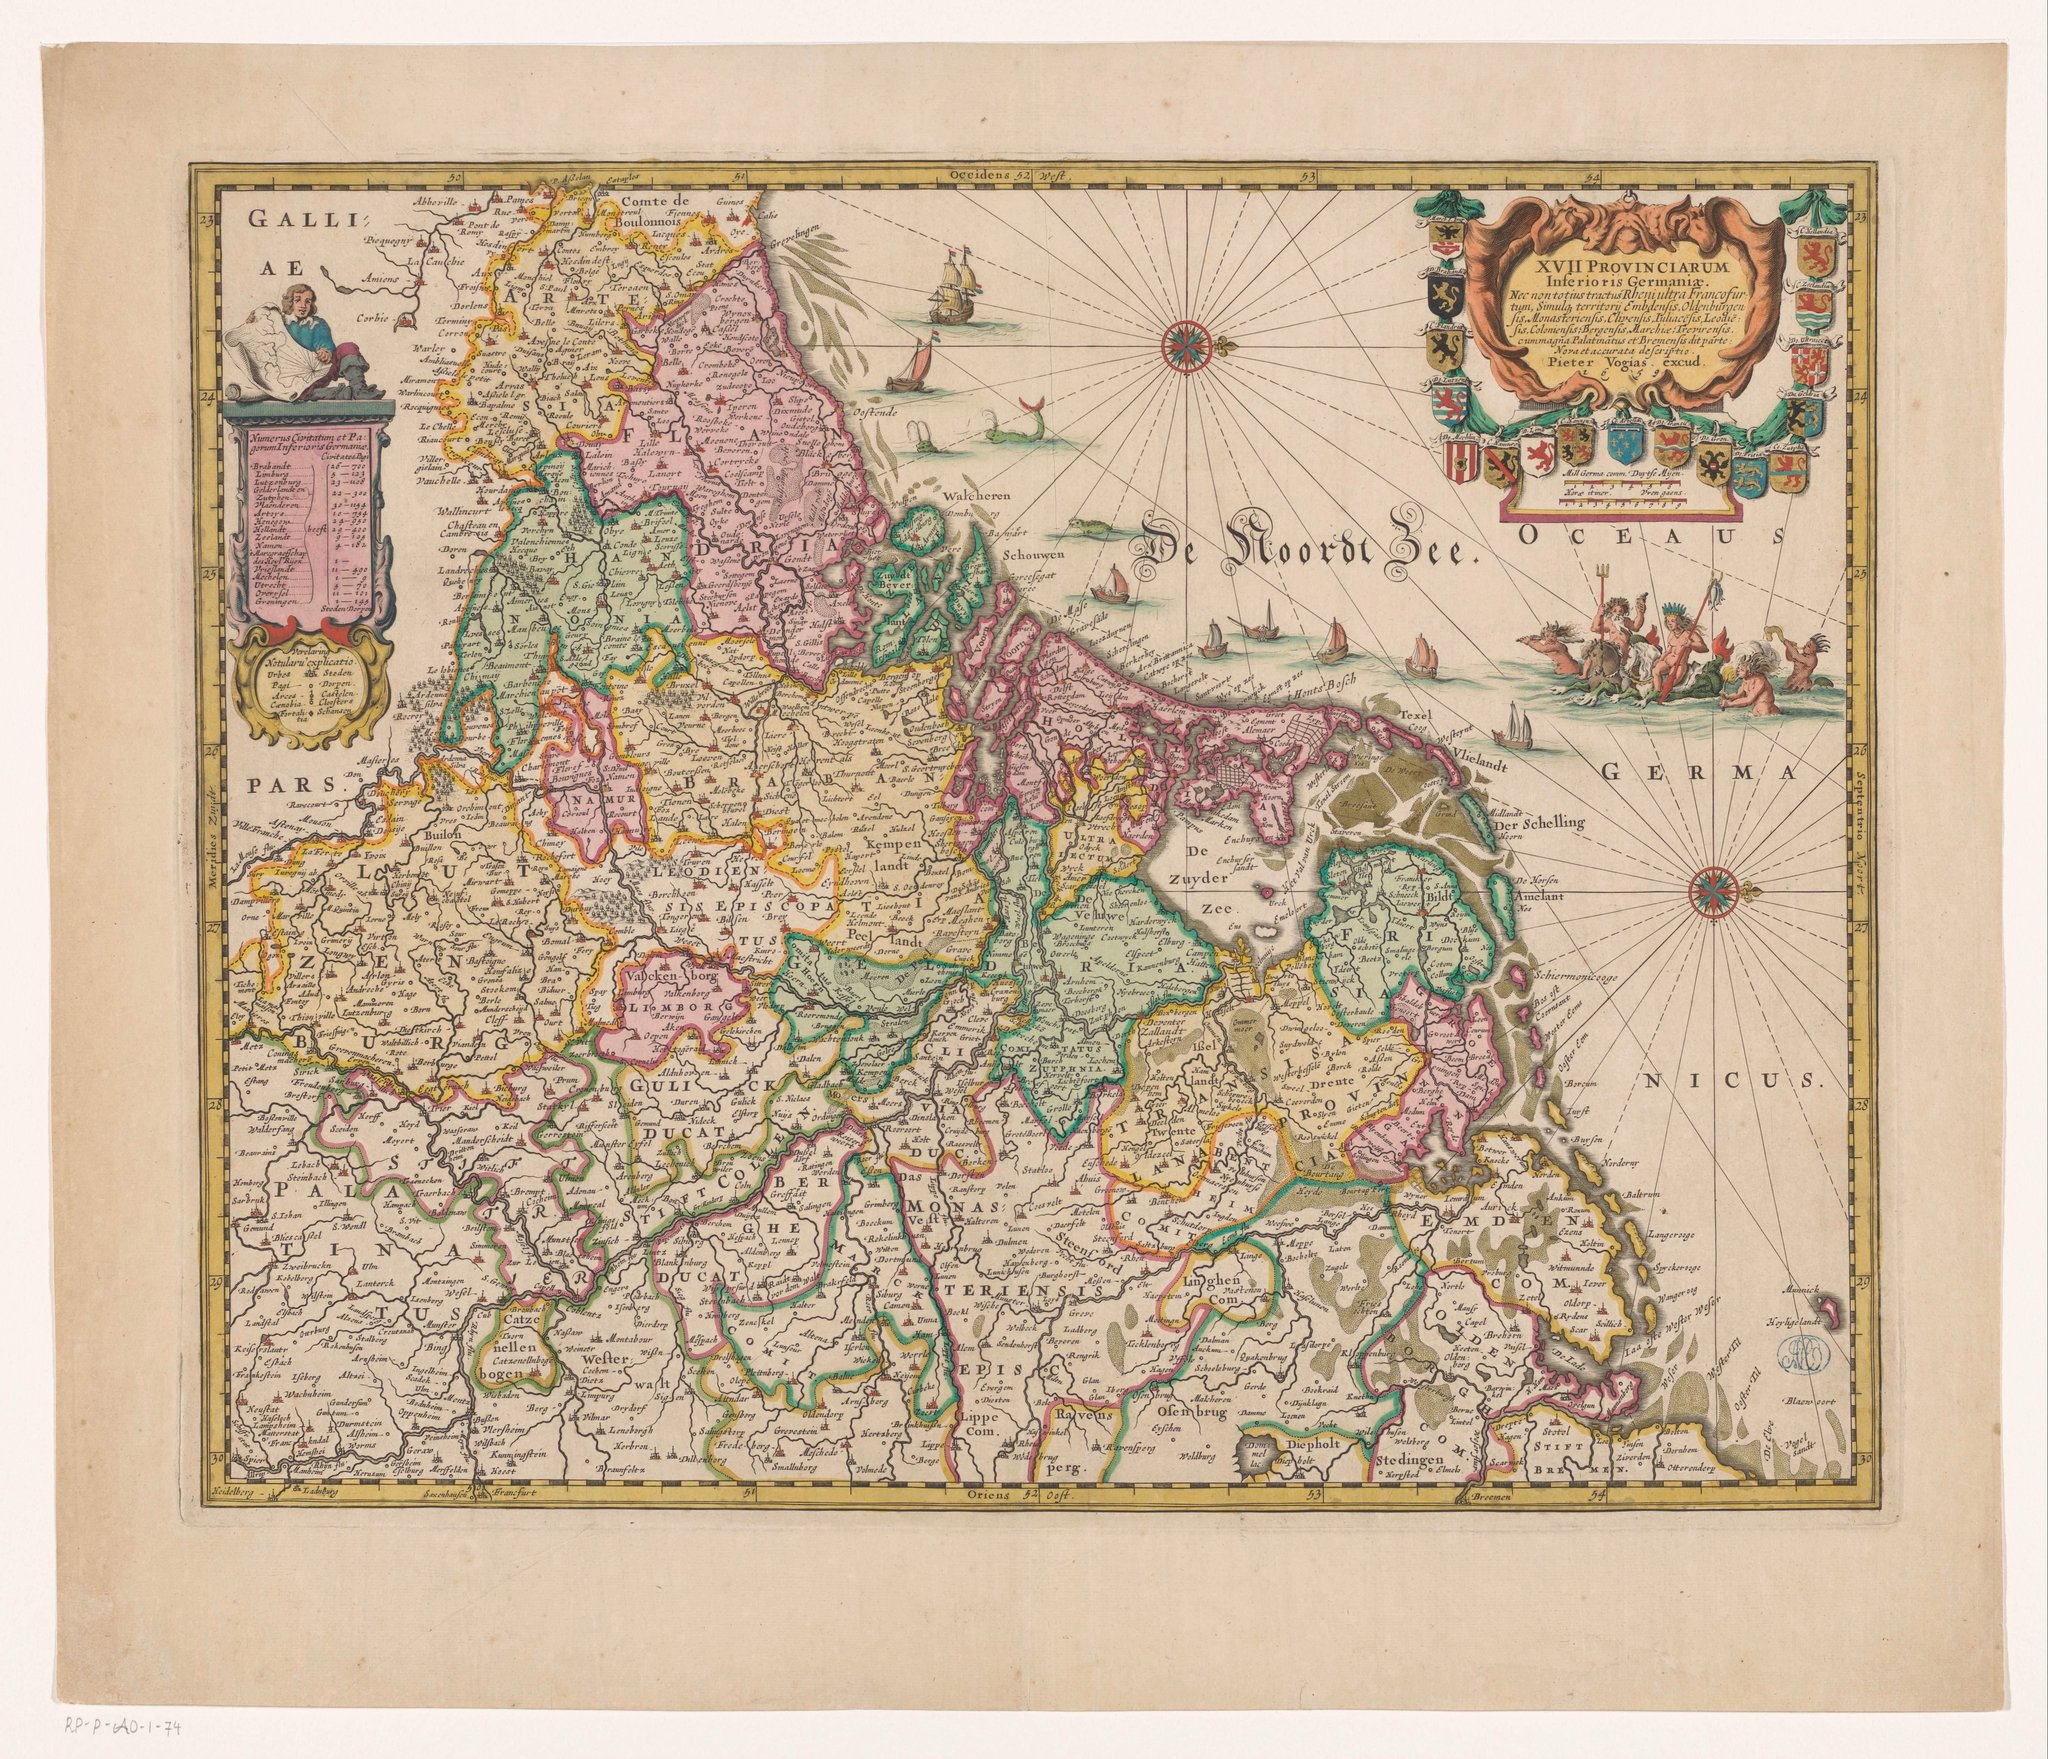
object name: print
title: XVII Provinciarum Inferioris Germaniae …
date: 1659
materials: paper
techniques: engraving, hand coloring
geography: amsterdam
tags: (story of) neptune (poseidon), coat of arms (as symbol of the state, etc.), triton(s), maps of separate countries or regions, other female roman deities: salacia, low countries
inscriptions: collector's mark: Lugt 2228, collector's mark: Lugt 195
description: Linksboven cartouche met overzicht van de provincies, topografische informatie en legenda. Op deze cartouche zit een man die een kaart vasthoudt. Rechtsboven titelcartouche omringd door wapens van de Zeventien Provinciën. Daaronder schaalstok: Mill Germa. comm. / Duytse mijen, Horae itiner. / Uren gaens. Hieronder een mythologische voorstelling met Neptunus, Salacia en drie tritons. Gradenverdeling langs de randen. Oriëntatie: noorden rechts.